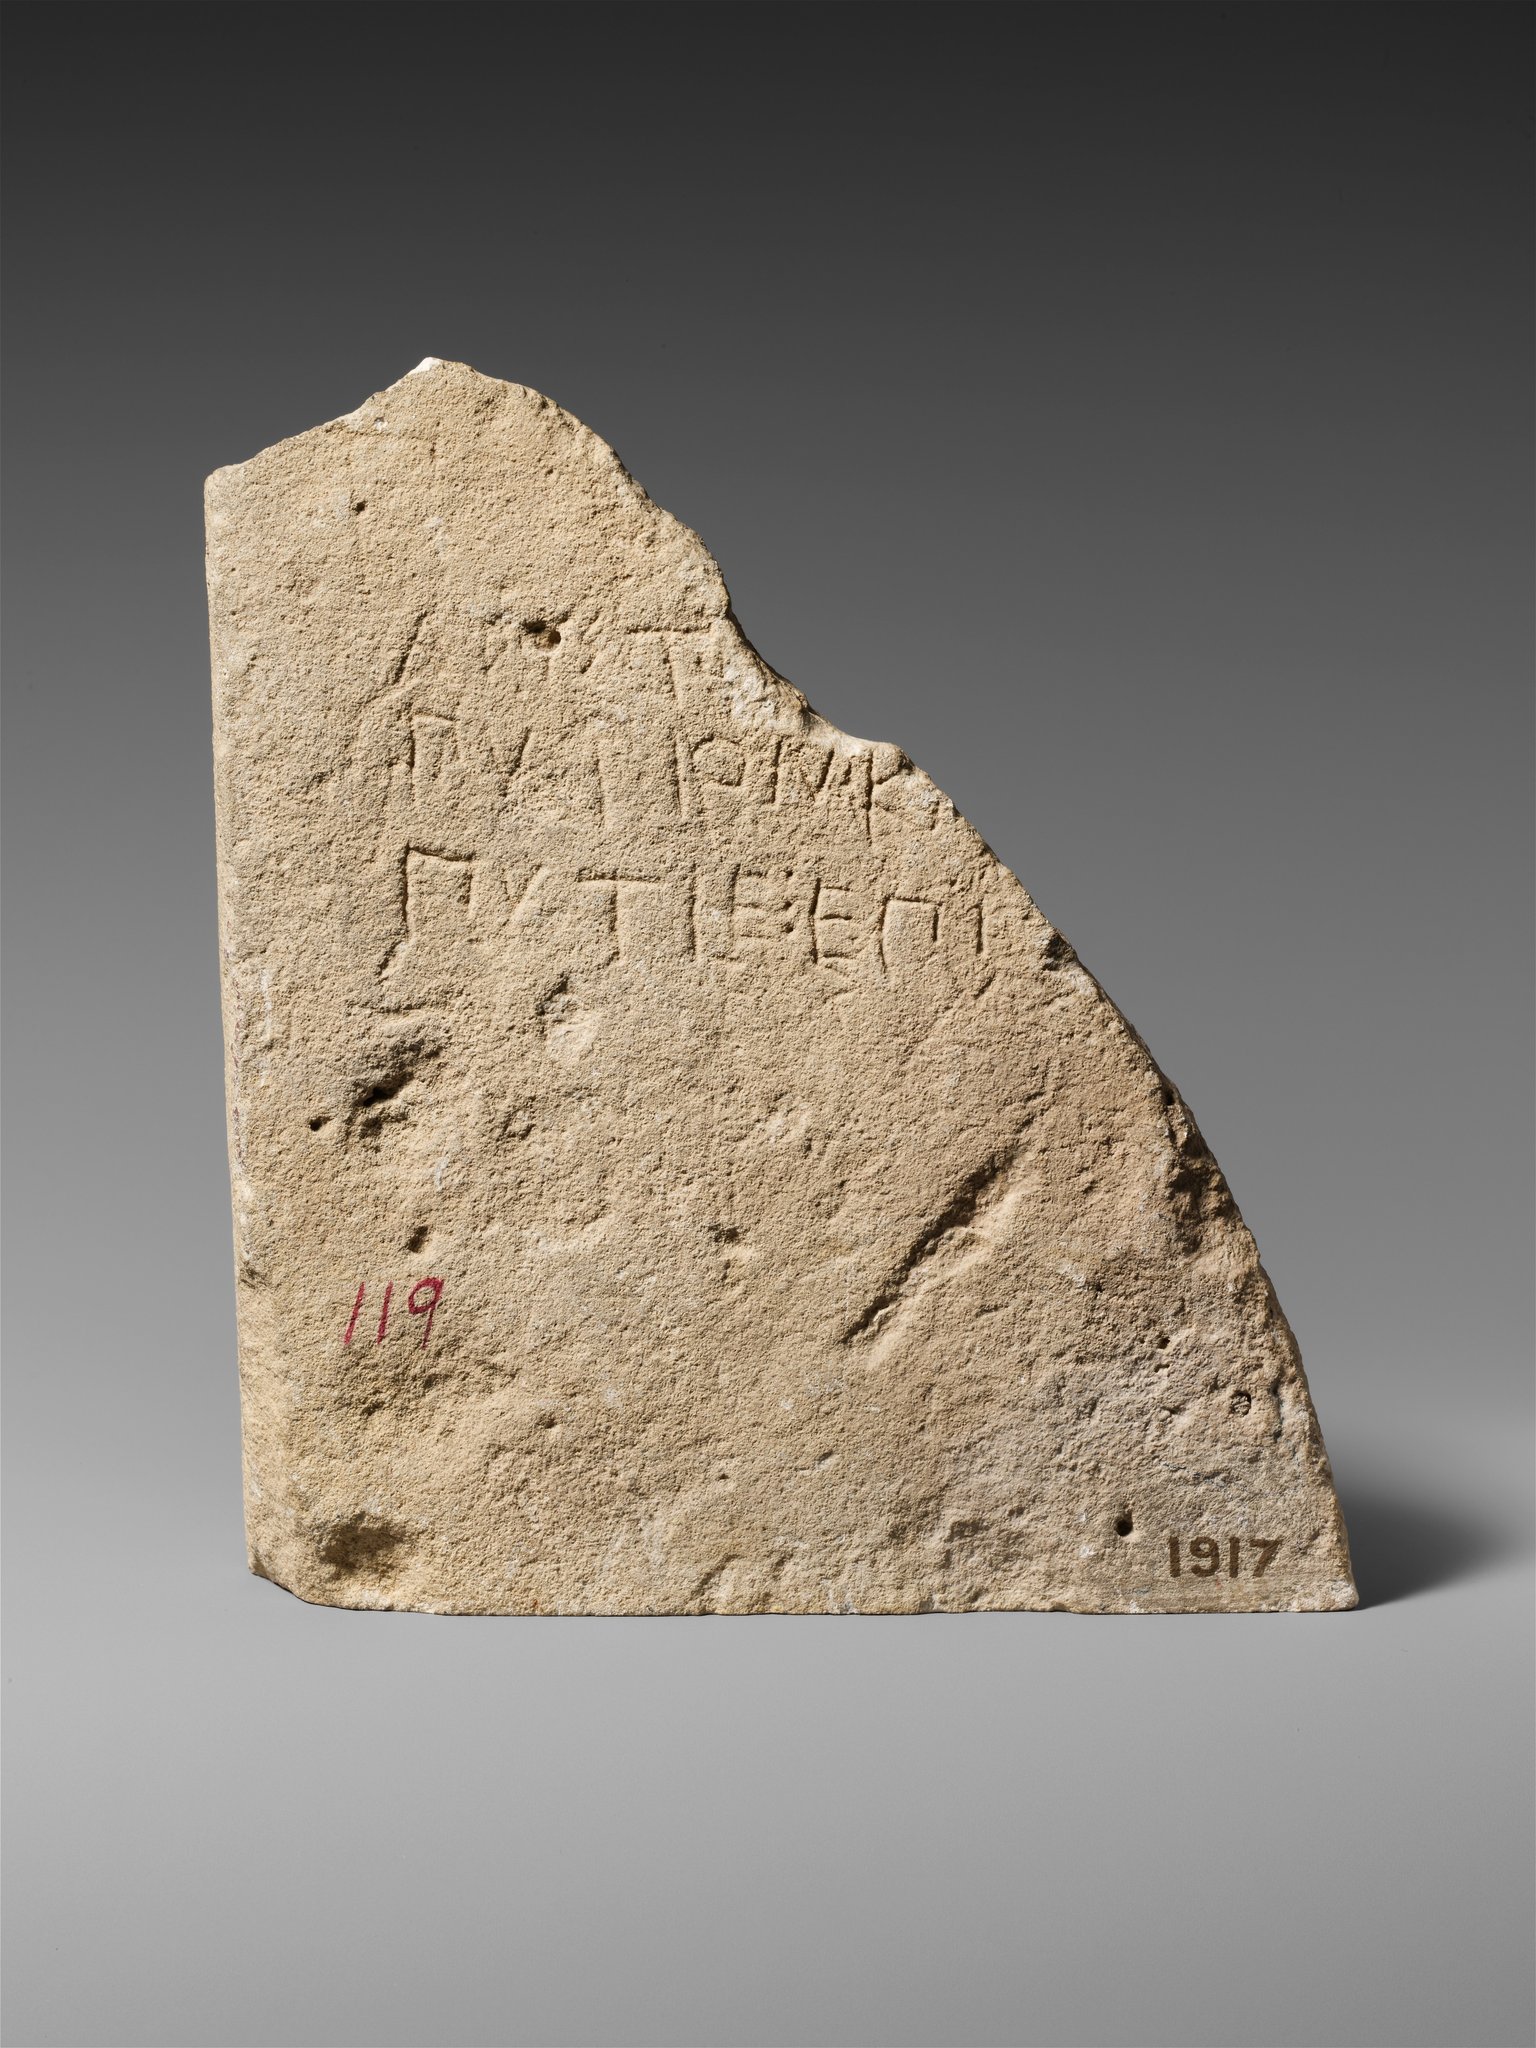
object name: slab inscribed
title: Limestone inscribed block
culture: cypriot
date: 500-401 BCE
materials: limestone